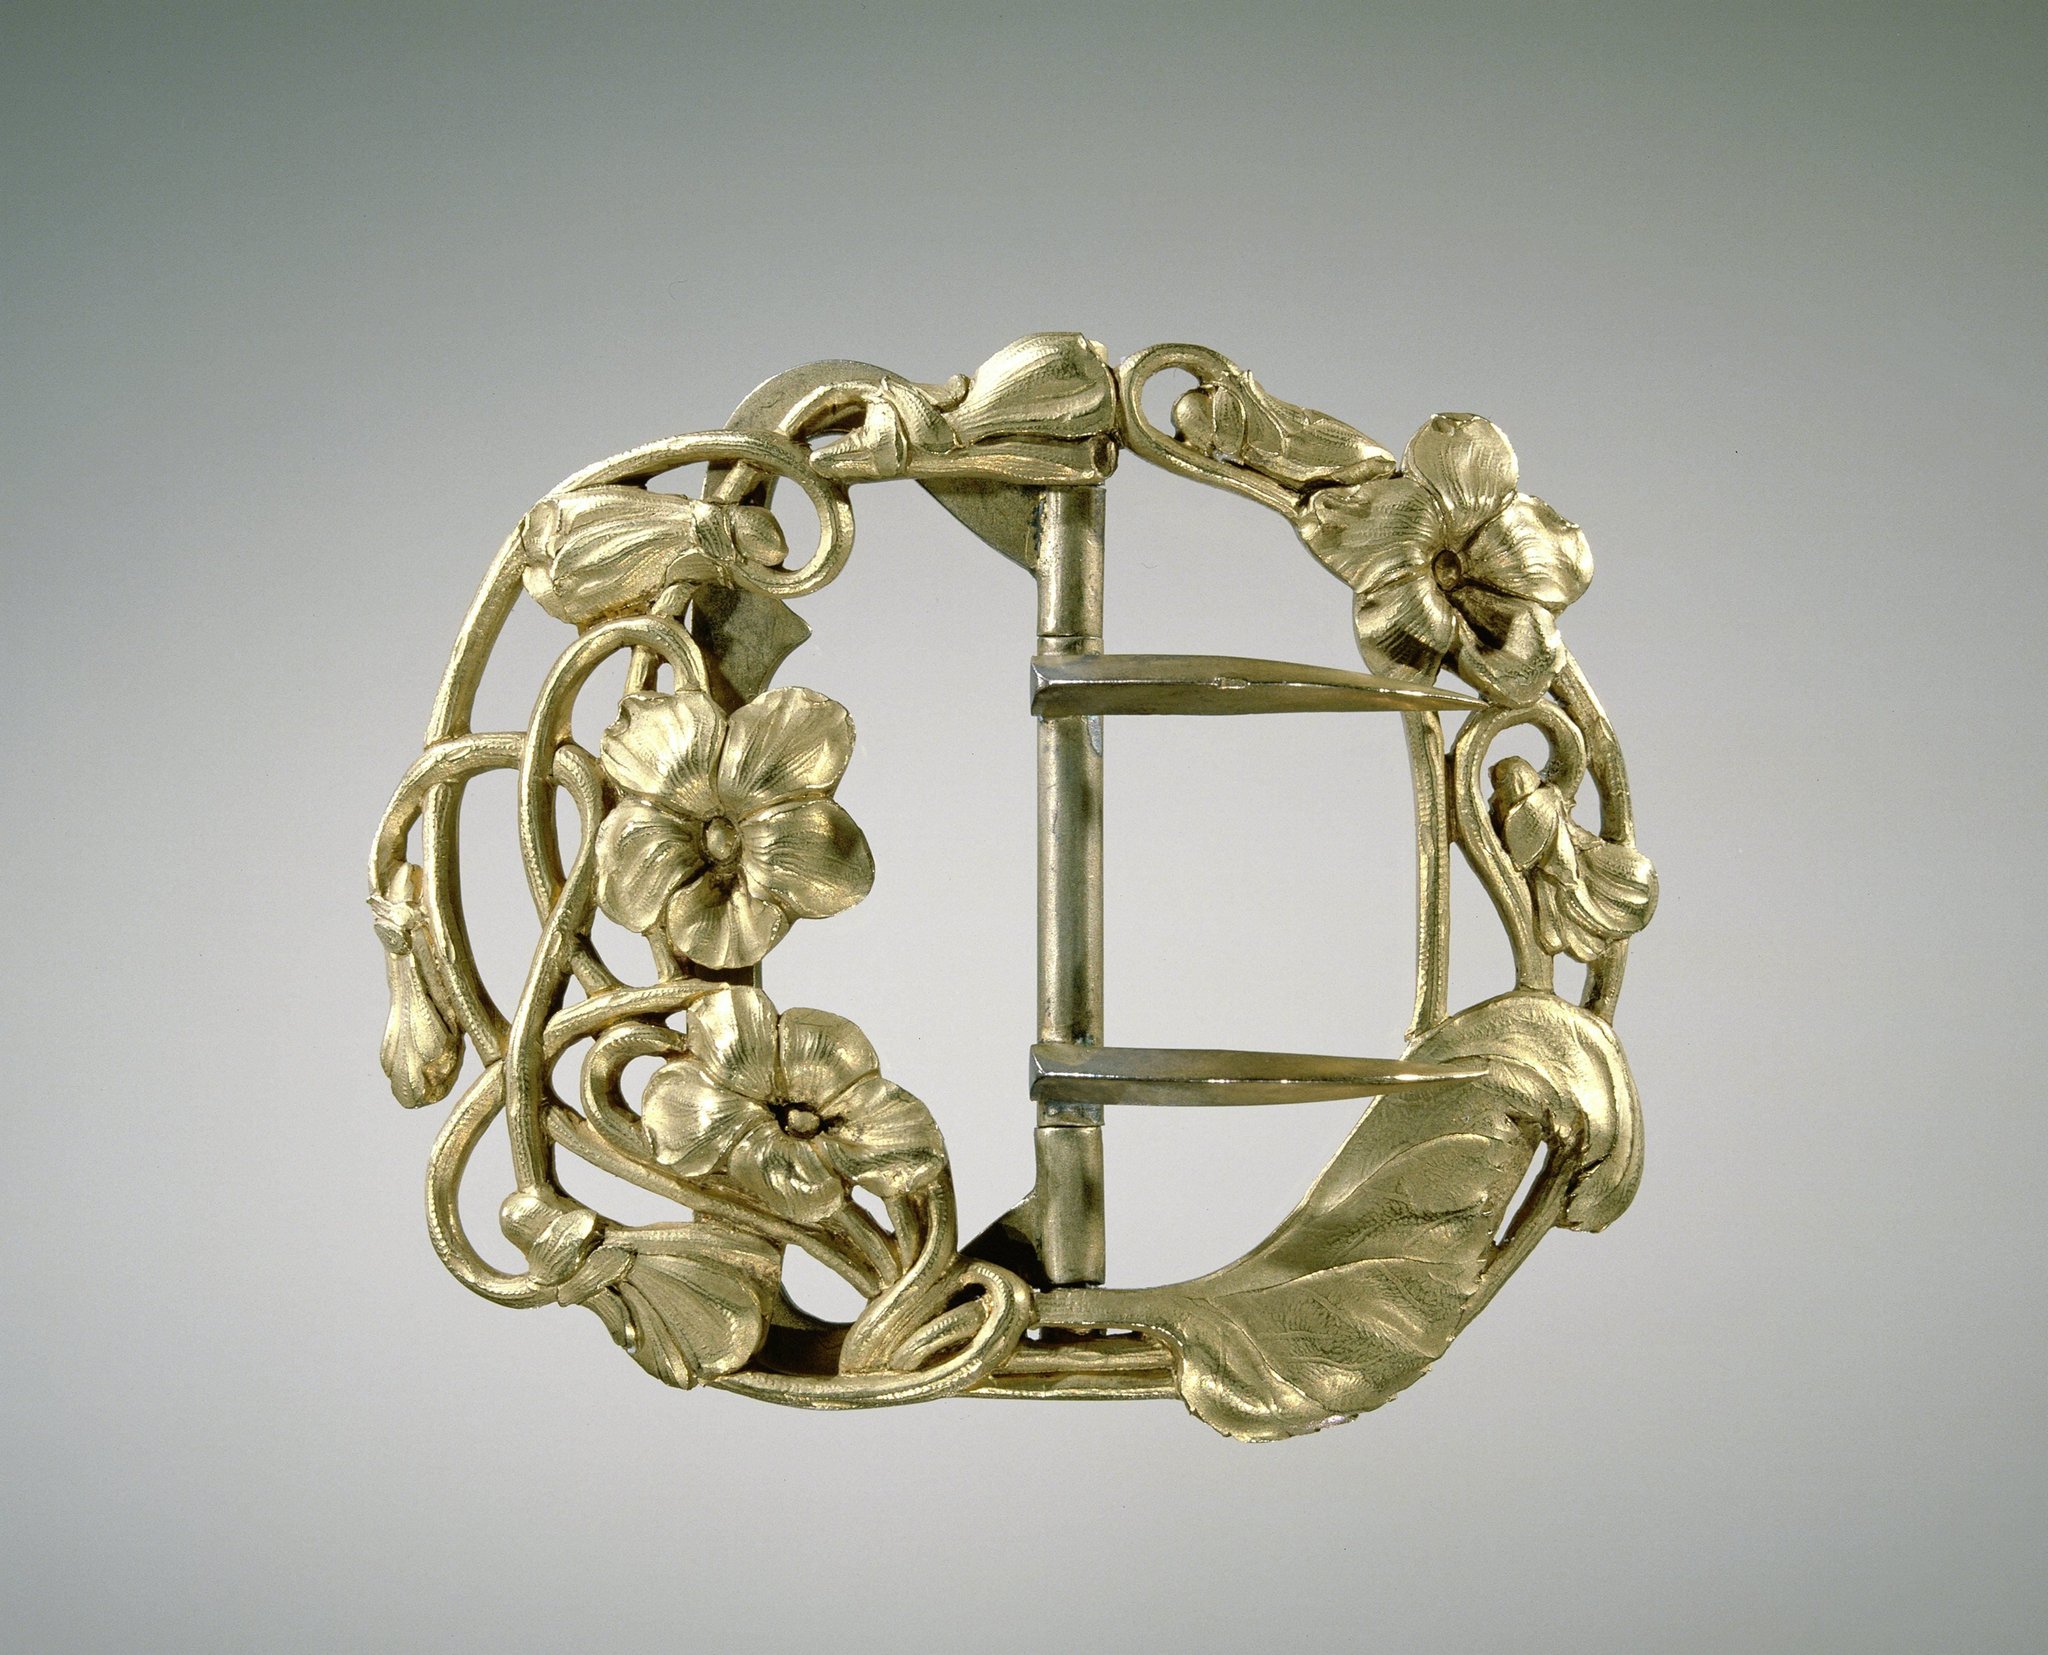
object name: buckle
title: Gesp versierd met anemonen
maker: Anonymous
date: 1900-1910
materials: gold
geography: paris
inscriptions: maker's mark: ‘CO in ruit’, alloy mark: ‘adelaarskop naar rechts (vanaf 1847)’, mark: ‘vogel naar links’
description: Clasp Gold Paris, c. 1900 - 1910